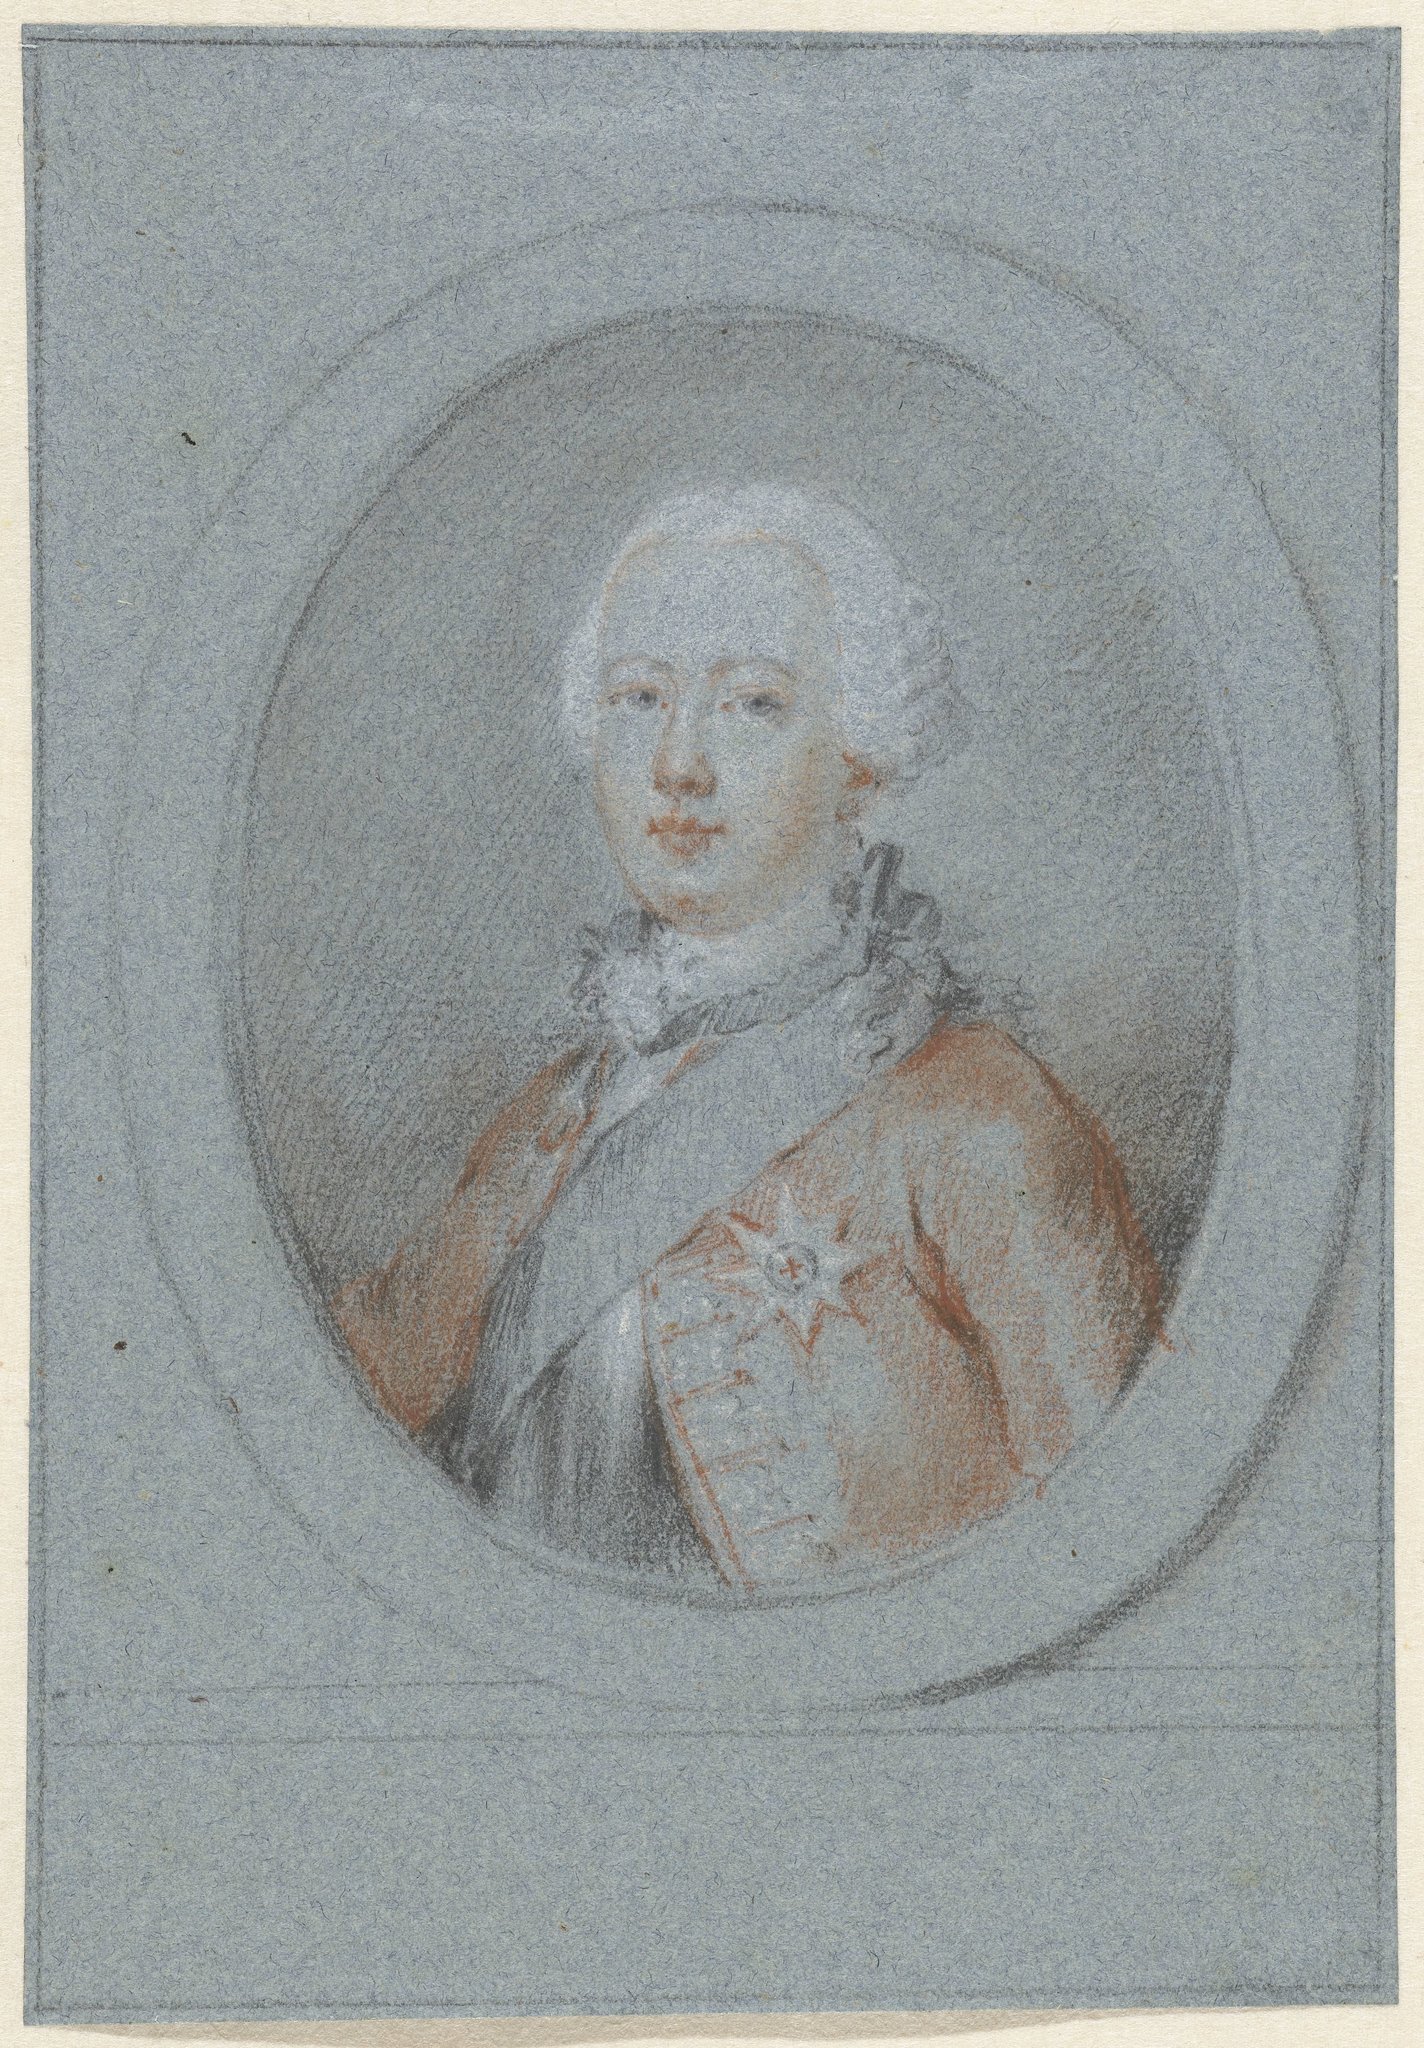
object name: drawing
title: Portret van een man met sjerp en ridderorde, naar rechts in ovaal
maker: aert schouman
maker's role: draughtsman, painter, print maker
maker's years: 1710-1792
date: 1760-1770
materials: chalk, paper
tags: anonymous historical person portrayed alone